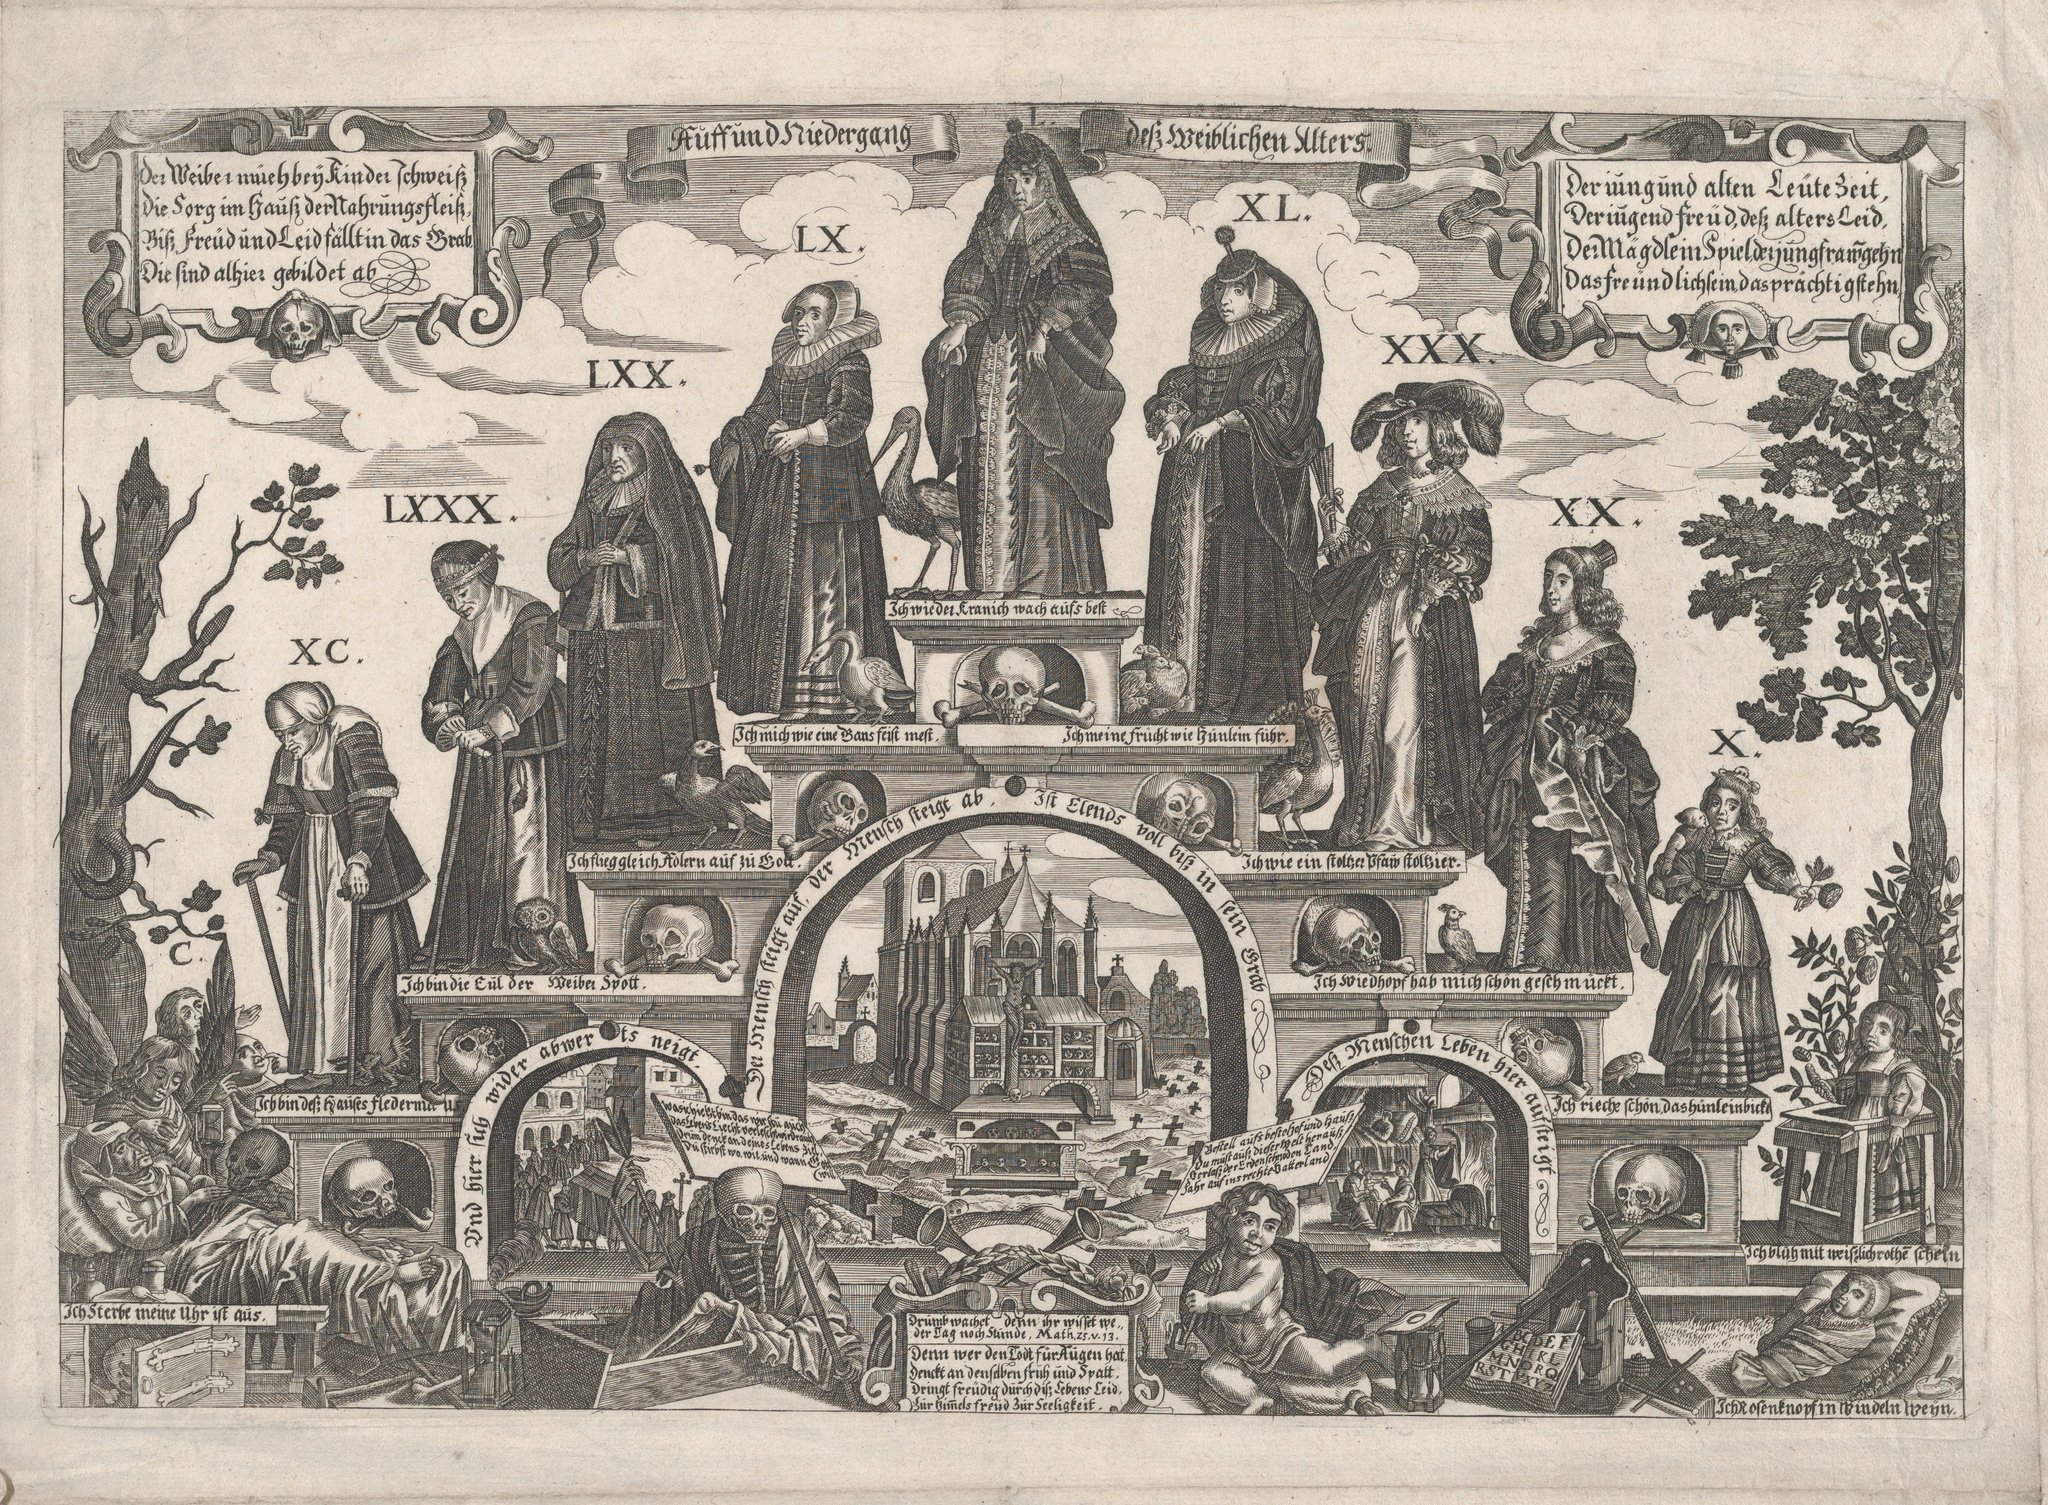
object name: print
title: The Eleven Ages of Women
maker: gerhard altzenbach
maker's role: artist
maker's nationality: german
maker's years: 1609-1672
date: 1609-1672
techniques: engraving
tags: birds,skeletons,children,women